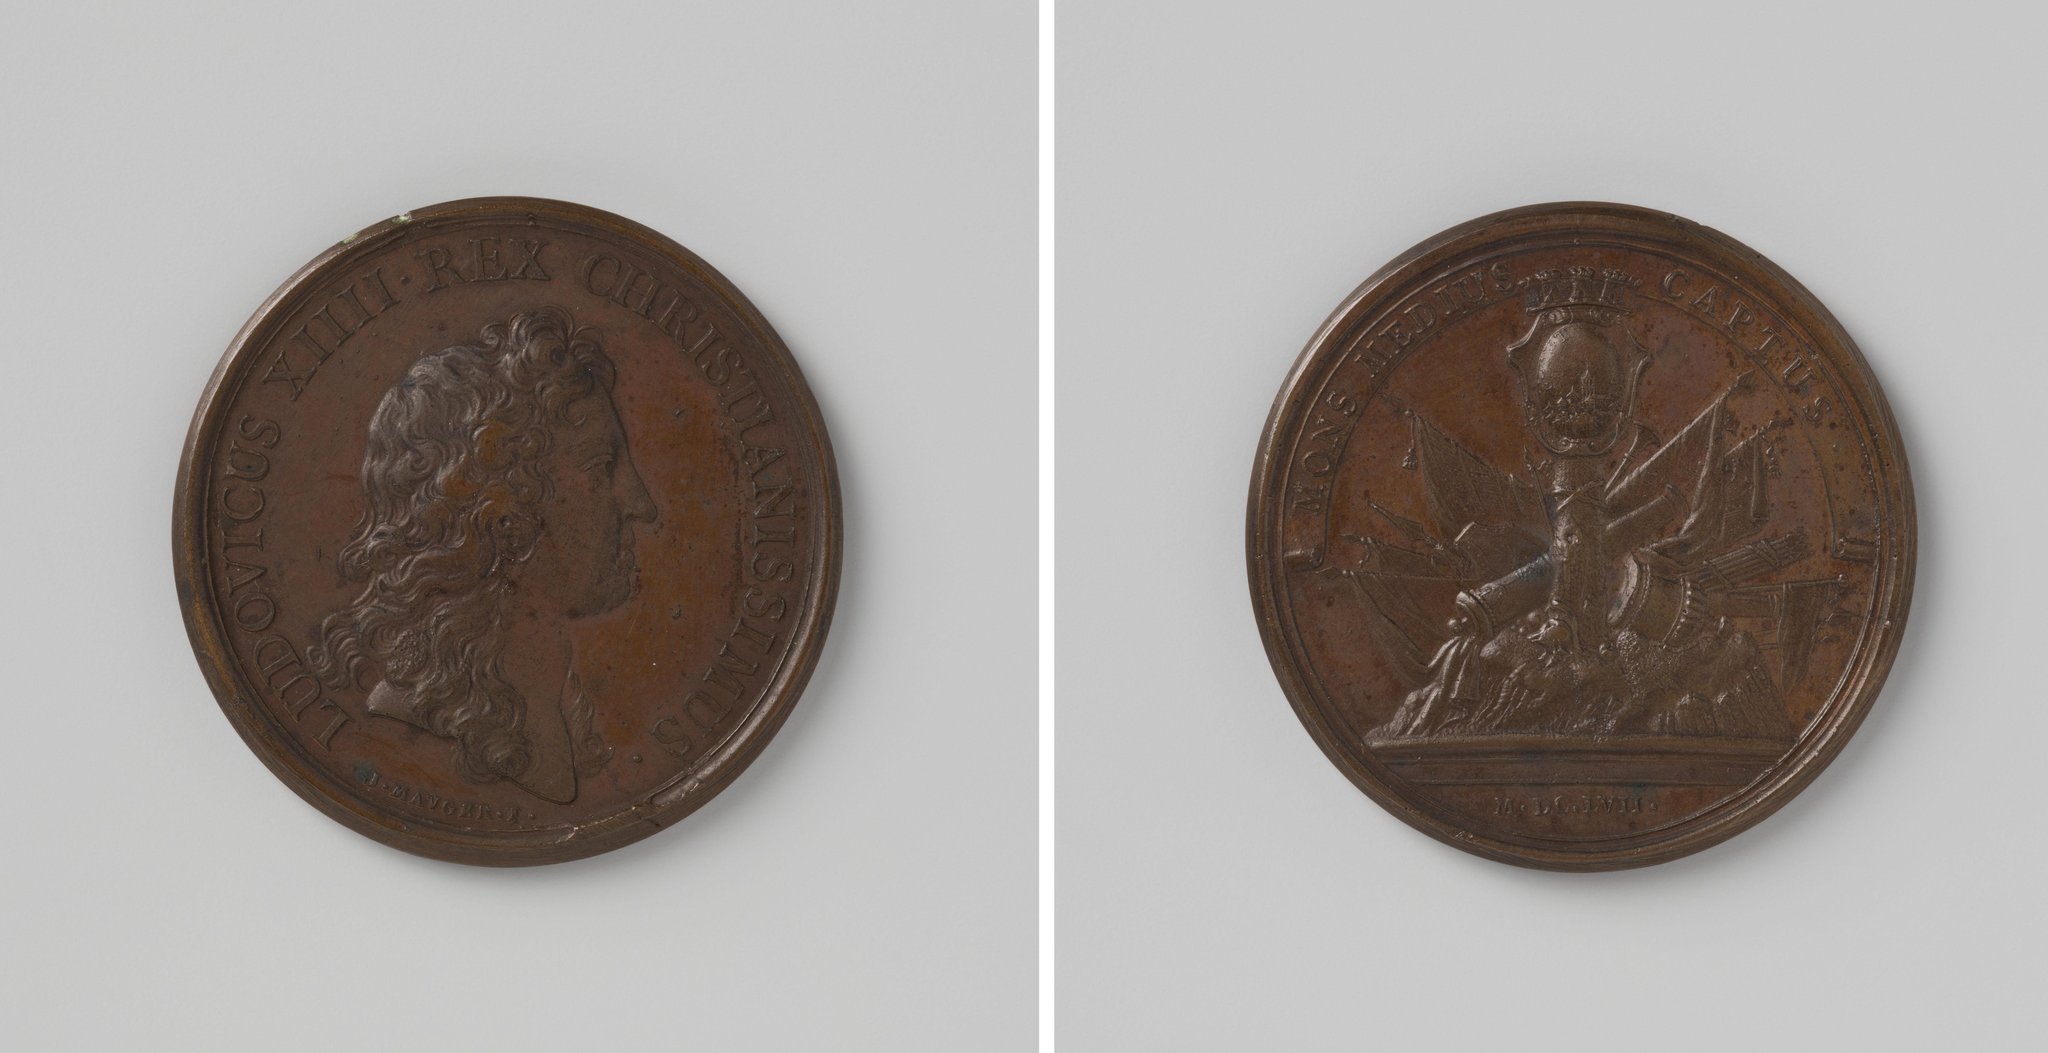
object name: history medal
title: Verovering van Montmedy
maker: jean mauger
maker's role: medailleur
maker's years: 1648-1722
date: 1699-1703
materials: bronze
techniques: striking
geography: paris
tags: lodewijk xiv (koning van frankrijk)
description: Bronzen penning. Voorzijde: borststuk jongeman (Lodewijk XIV) binnen omschrift. Keerzijde: op bergtop zegeteken van oorlogstuig met daarboven gekroond wapenschild binnen omschrift; afsnede: jaartal